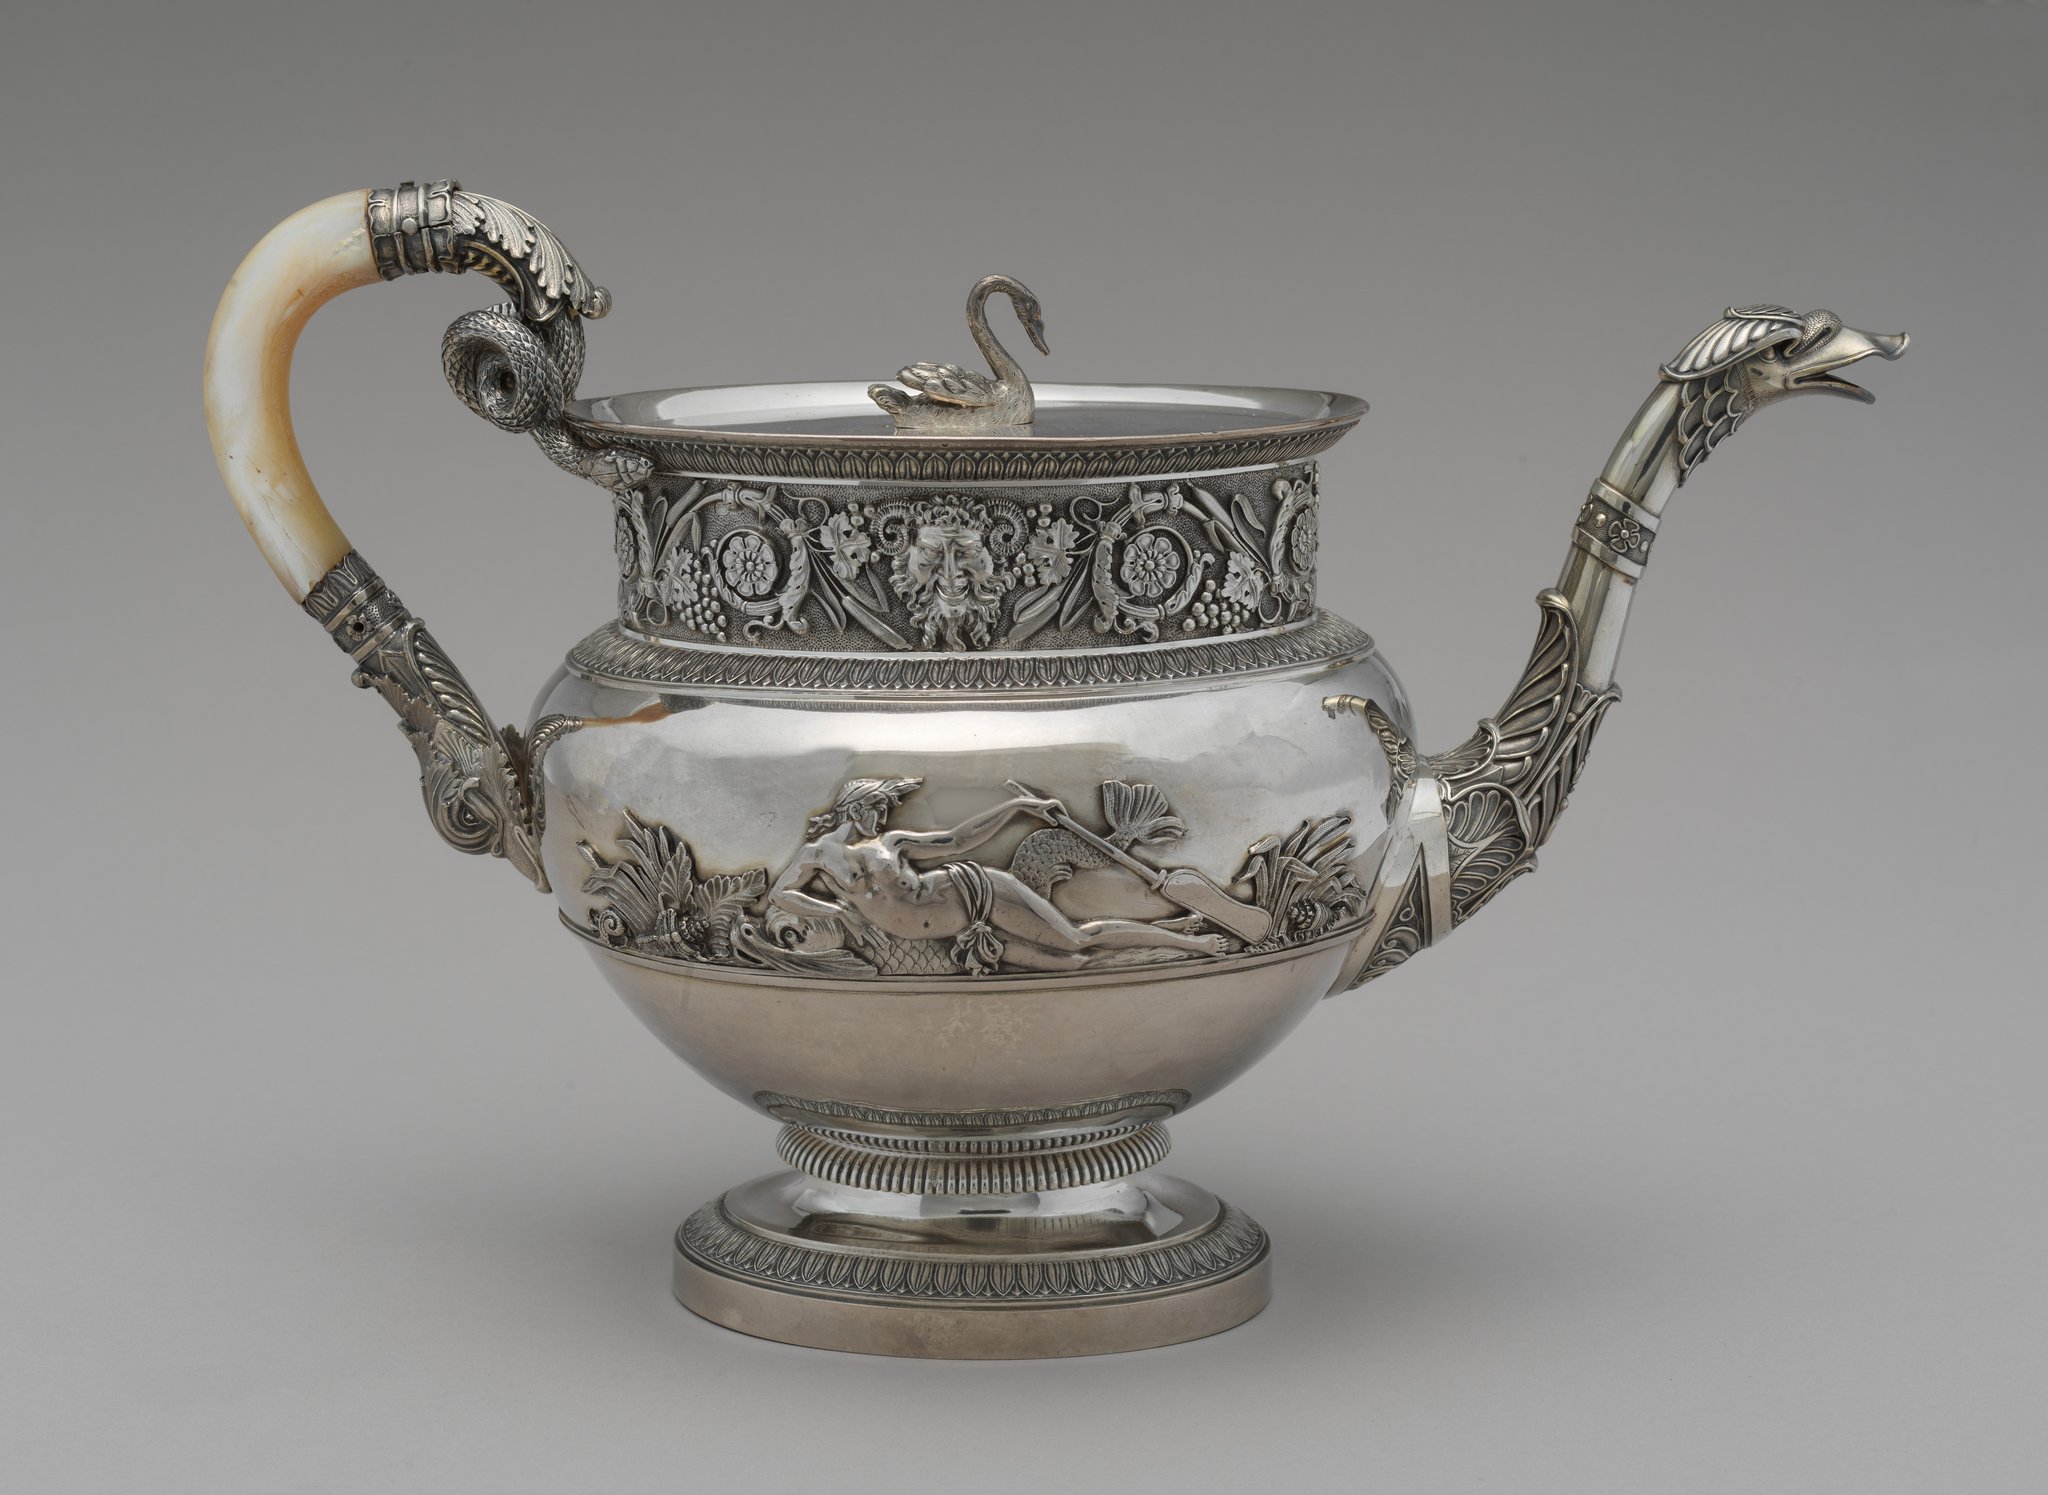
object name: teapot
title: Teapot (part of a service)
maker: marc jacquart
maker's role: maker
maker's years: 1767-1859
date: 1809-1819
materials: mother of pearl, silver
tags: human figures